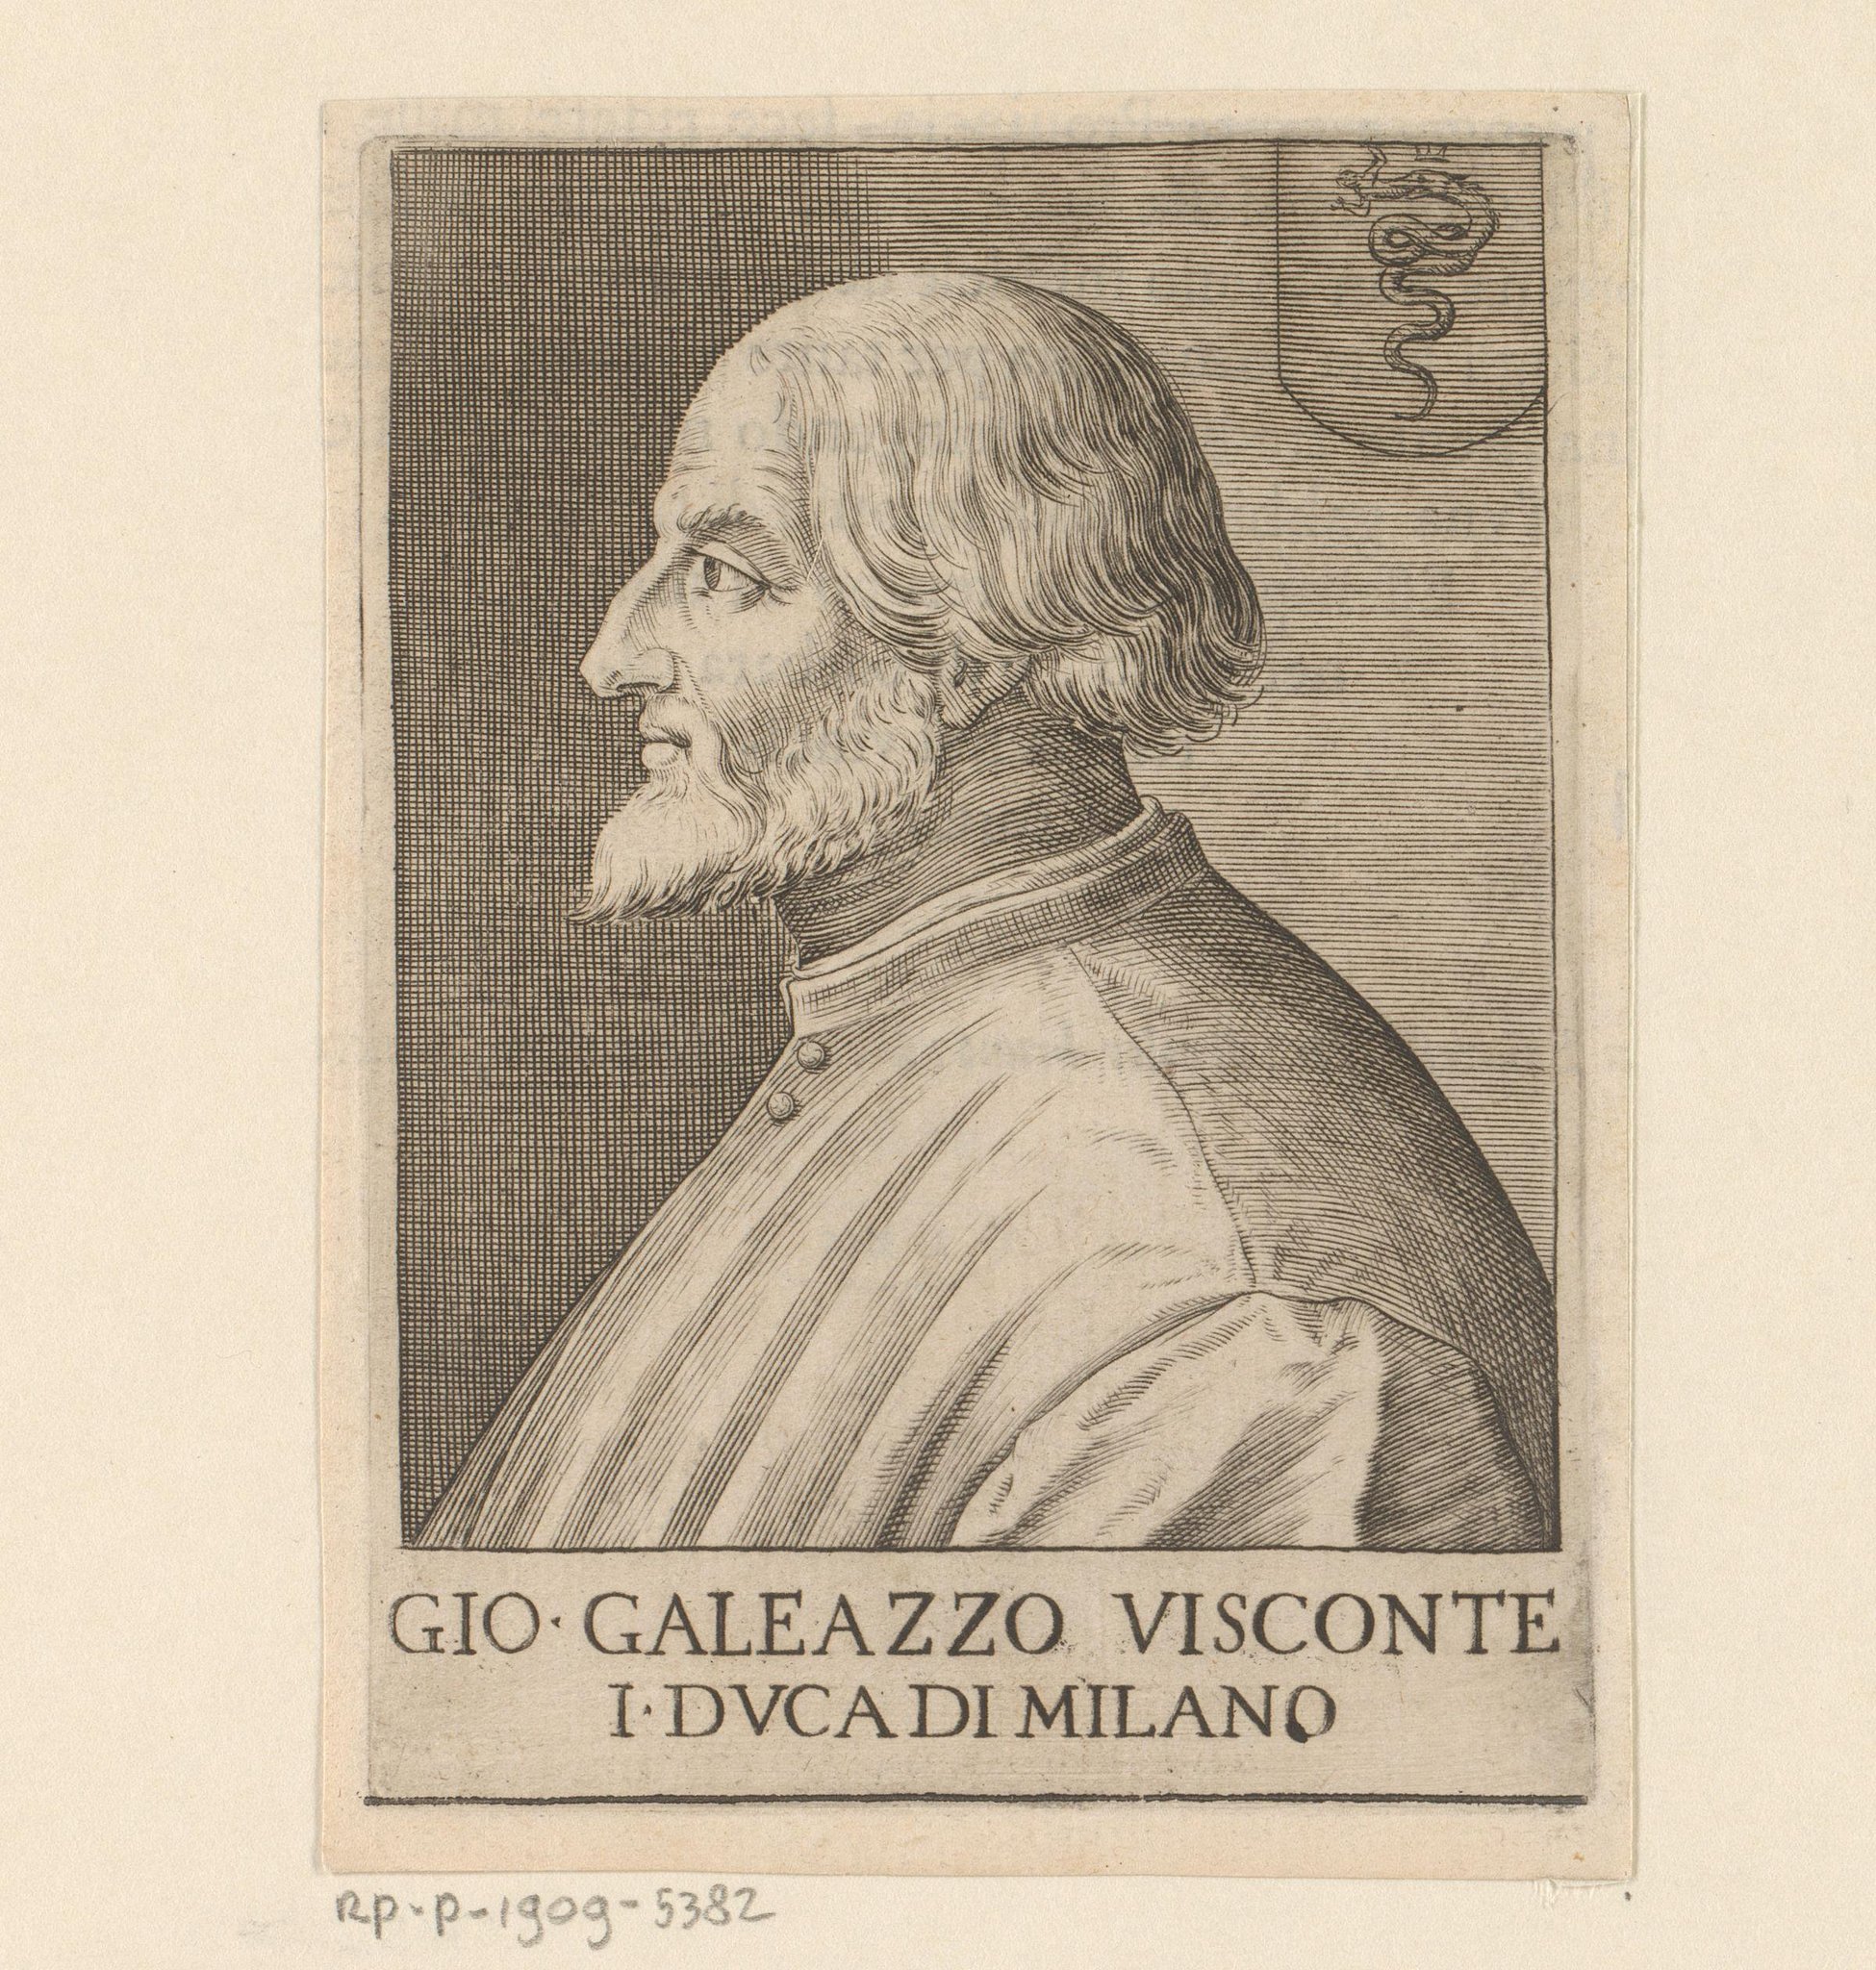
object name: book illustration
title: Portret van Gian Galeazzo Visconti, hertog van Milaan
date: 1646-1647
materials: paper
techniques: engraving, letterpress printing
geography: rome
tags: historical persons, armorial bearing, heraldry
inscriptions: collector's mark: Lugt 2228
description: Prent uit: Ritratti et elogii di capitani Illustri. Che ne'secoli moderni hanno gloriosamente guerreggiato. Rome: Filippo de'Rossi en Vitale Mascardi, 1646, p. 66. Prent ook gebruikt in dezelfde editie van 1647. Eerdere staten van prent in ieder geval gebruikt in: Ritratti et elogii di capitani Illustri. Rome: Pompilio Totti en Andrea Fei, 1635. En in: Ritratti di cento capitani illustri con li lor Fatti in guerra (…), Rome: Domenico Gigliotti, 1596.